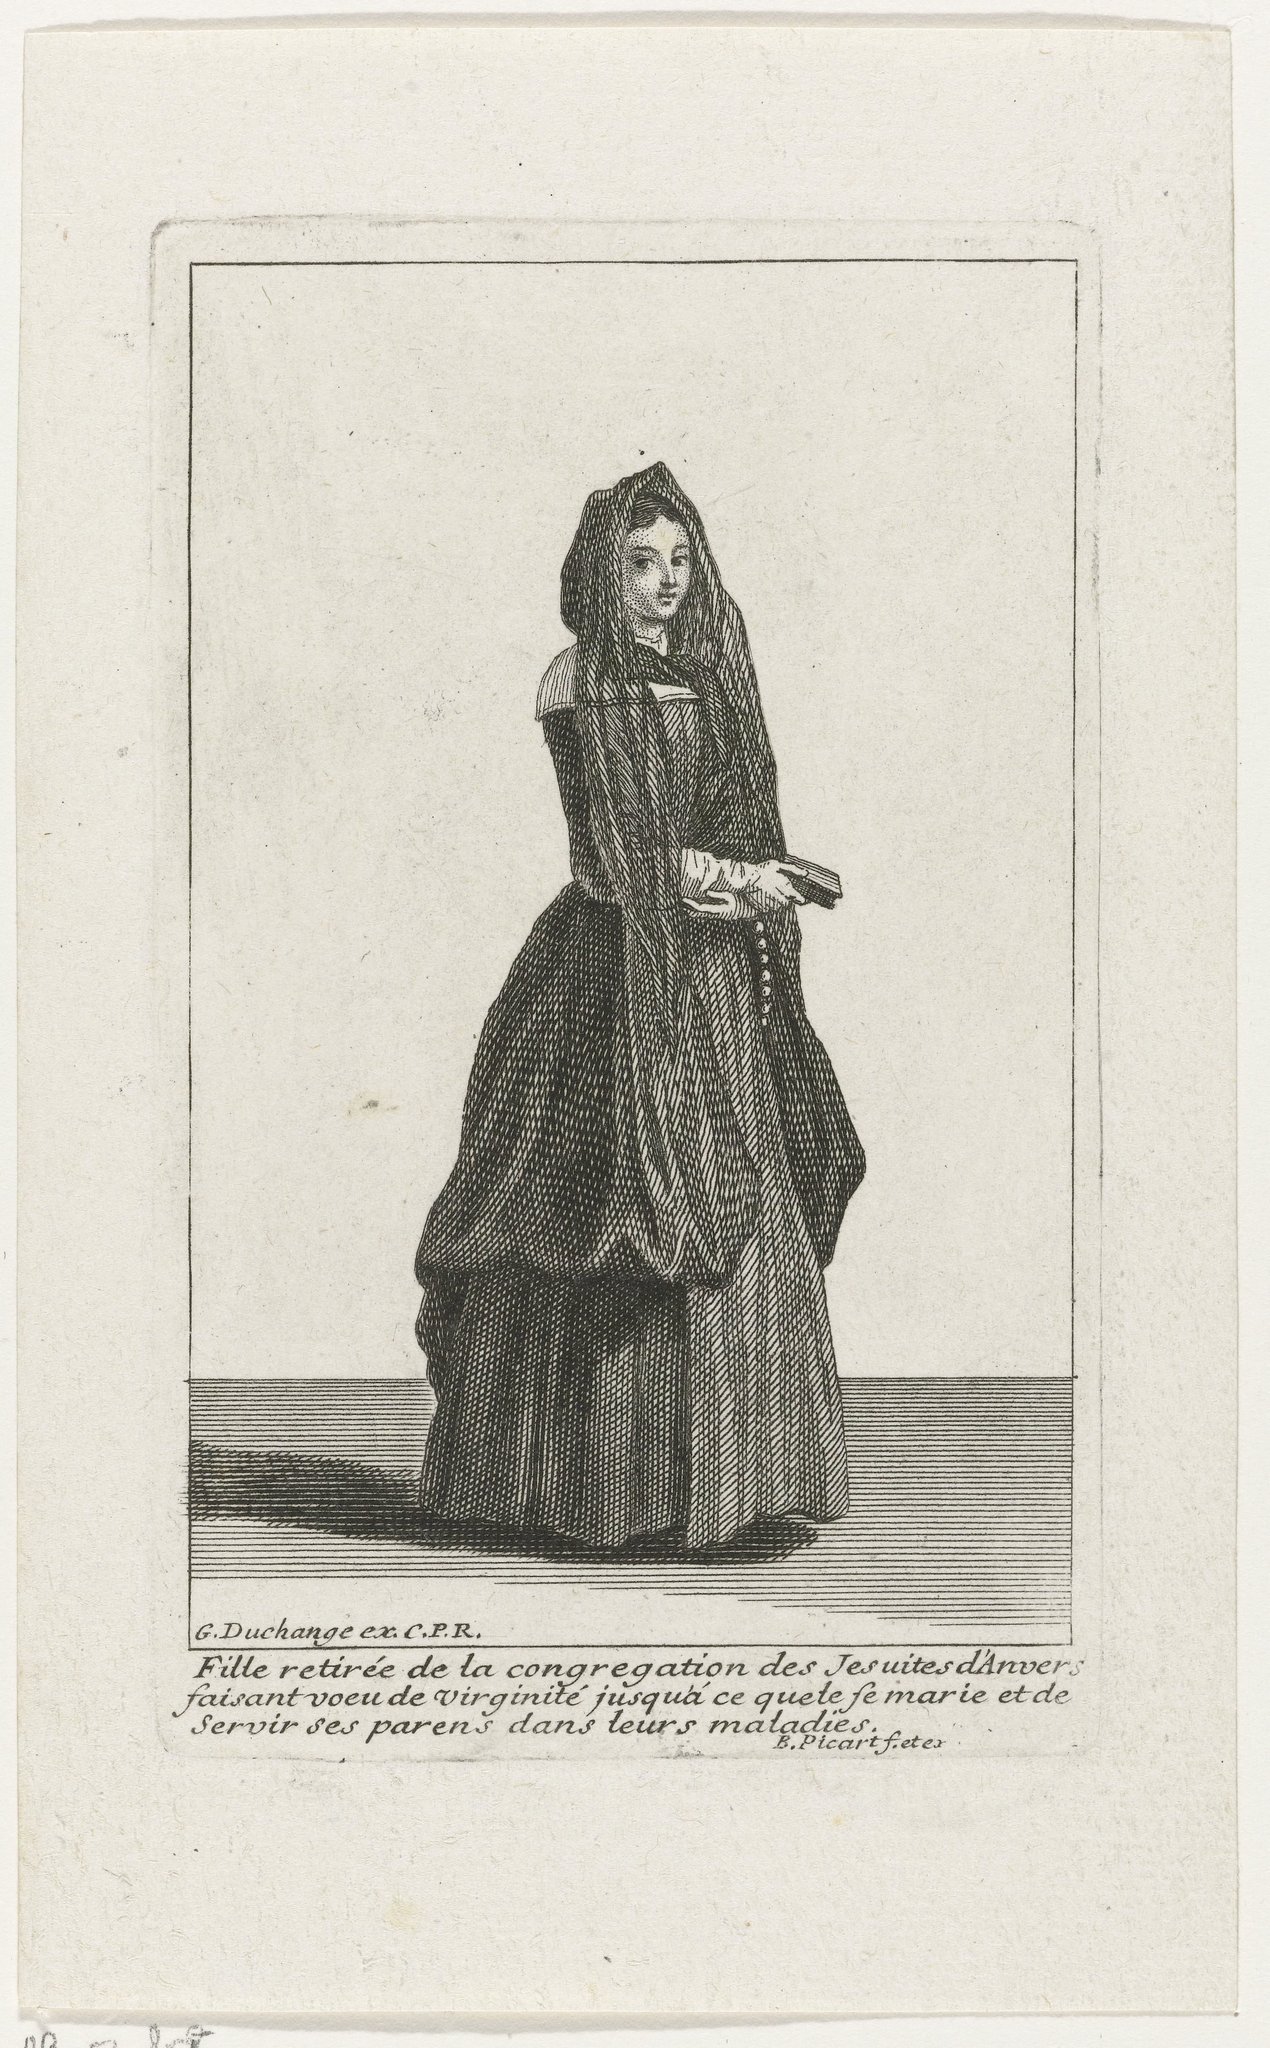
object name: print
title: Jong meisje uit de gemeente van Antwerpse Jezuïten voordat ze in het huwelijk treedt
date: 1704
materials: paper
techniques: engraving, etching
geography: paris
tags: nun(s), folk costume, regional costume, antwerp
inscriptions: collector's mark: Lugt 240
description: Figuur in eigentijds kostuum. In de marge een drieregelig onderschrift in het Frans.